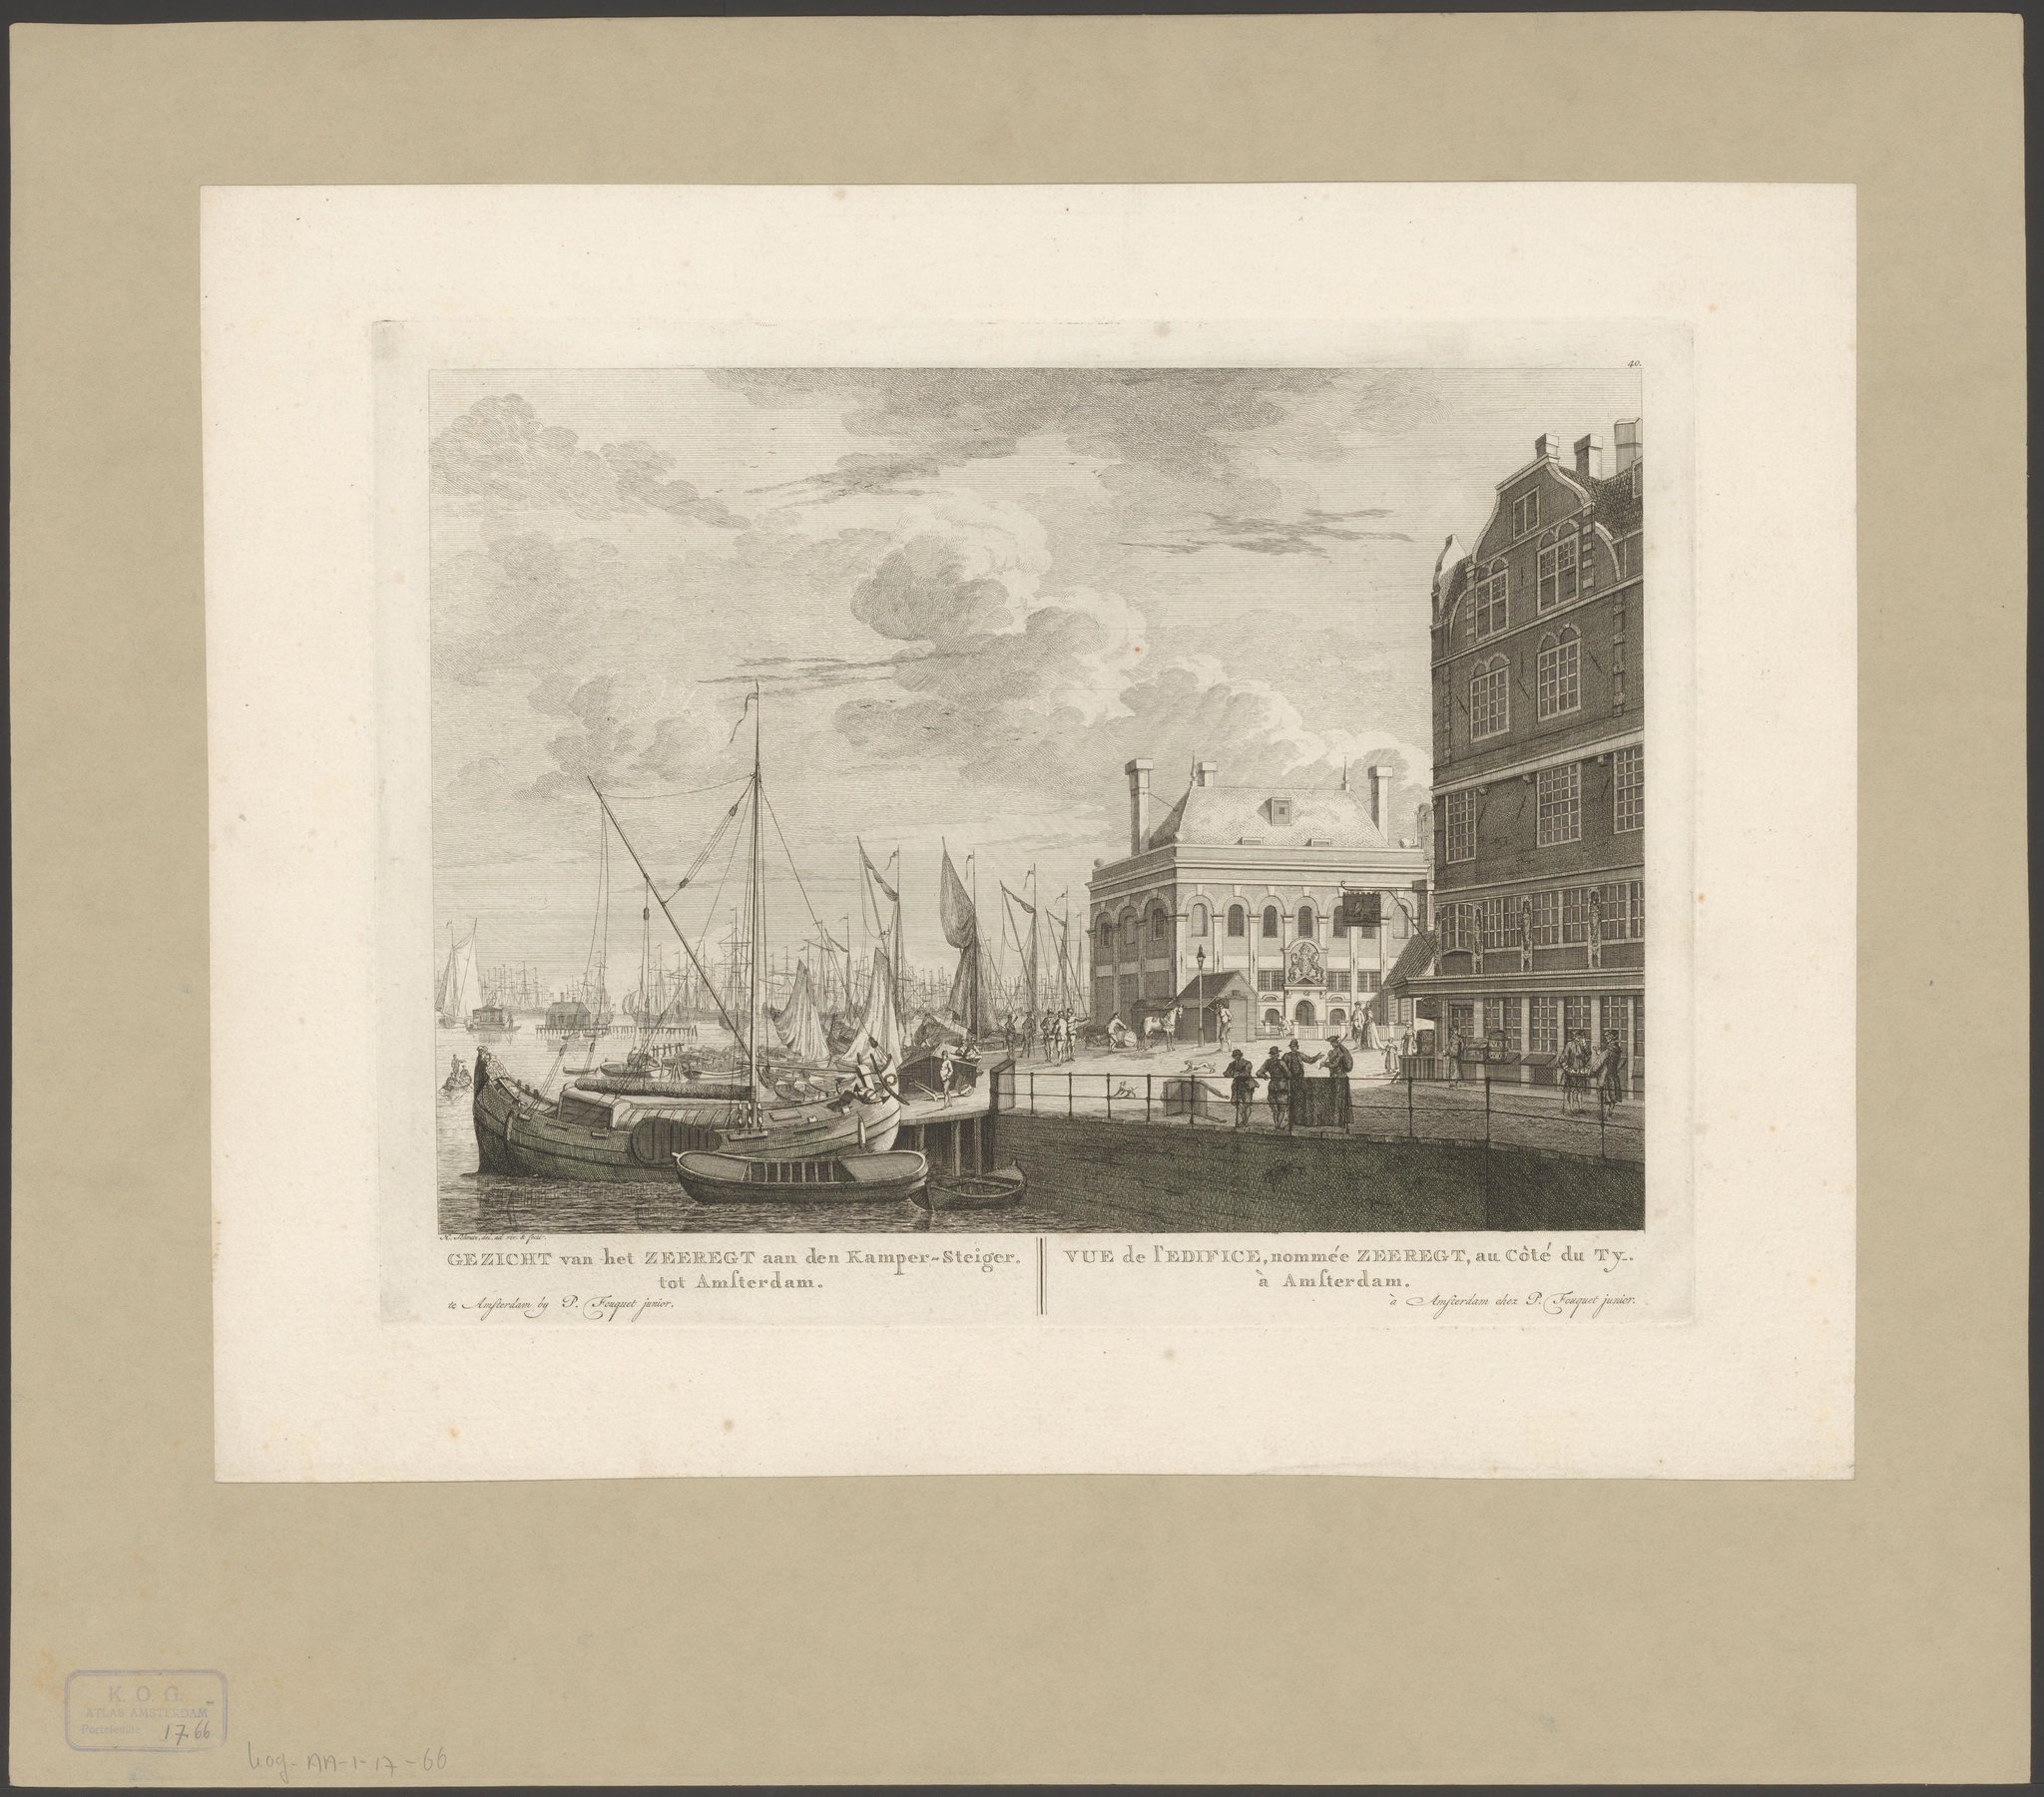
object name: print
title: Gezicht op het gebouw Zeerecht aan de Kampersteiger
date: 1770-1783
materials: paper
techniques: engraving, etching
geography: amsterdam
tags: sailing-ship, sailing-boat, city-view in general; 'veduta', river, façade (of house or building)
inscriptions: collector's mark: ‘17.66’ Lugt 1641b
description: Deze prent is ook gebruikt in de zogenaamde Atlas van Fouquet.* Pierre Fouquet gaf vanaf 1760 stadsgezichten van Amsterdam - naar tekeningen van verschillende kunstenaars, gemaakt door verschillende prentmakers - uit. Deze prenten werden aanvankelijk los of in series verkocht. Zoals toen gebruikelijk kon de koper de prenten zelf laten inbinden. Hiertoe gaf Fouquet tussen 1778 en 1783 een titelblad, plattegrond en inhoudsopgave van de tot dusver 100 uitgegeven prenten uit (1). Gezien de inhoud afhankelijk was van wat de koper had verzameld verschilt de inhoud van de verschillende bewaarde Fouquetatlassen onder deze titel sterk. Ook zijn er exemplaren bekend waar tevens andere prenten aan zijn toegevoegd. Omdat er behoefte bleek aan uitleg bij de platen werd in 1783 een nieuwe versie van de atlas uitgegeven, aangevuld met tekst en twee prenten. De aangegeven volgorde veranderde maar de platen van de al eerder uitgegeven prenten bleven ongewijzigd. Deze uitgave werd in opdracht van Fouquet gedrukt bij Daniël Jean Changuion en Petrus den Hengst (2). Een tiental platen werd bijgewerkt en verscheen, met nieuw impressum, in het vervolg van Wagenaars geschiedenis van Amsterdam, uitgeven door Petrus Conradi en Folkert van der Plaats (3). Een aantal jaar na het overlijden van Fouquet kwam Evert Maaskamp met een nieuwe uitgave van de atlas, met verbeterde tekst en toevoeging van twee prenten. Op alle platen verwijderde hij het oude en liet hij zijn eigen impressum zetten (4). De huidige staat van de prent komt voor in exemplaren van de onder (1) en (2) genoemde werken. * Onder de Atlas van Fouquet of Fouquetatlas verstaan we de hieronder vermelde publicaties (1), (2) en (4). (1). Afbeeldingen van de wyd-vermaarde koopstad Amsterdam benevens des zelvs voornaamste gebouwen en gezigten alle naar het leeven getekend / Receuil des edifices les plus considerables et des plus belles vues, de la fameuse ville d'Amsterdam, dessinées d'après nature. Amsterdam: Pierre Fouquet, 1778-1783. (2). Nieuwe atlas, van de voornaamste gebouwen en gezigten der stad Amsterdam, met derzelver beknopte beschryvingen. 2 delen. Amsterdam: Daniël Jean Changuion en Petrus den Hengst [in opdracht van Pierre Fouquet], 1783. (3). Stijl, Simon. Amsterdam, in zyne geschiedenissen, voorregten, koophandel, gebouwen, kerkenstaat, schoolen, schutterye, gilden en regeeringe, beschreeven. Om te dienen ten vervolge op het werk van Jan Wagenaar (…). 10 delen. Amsterdam en Harlingen: Petrus Conradi en Folkert van der Plaats, 1788-1801. (4). Nieuwe atlas, van de voornaamste gebouwen en gezigten der stad Amsterdam. Met derzelver beknopte beschryvingen. Amsterdam: Evert Maaskamp, 1805. * Het aantal vermelde staten is gebaseerd op het aantal gevonden staten. Mogelijk zijn er meer staten van deze prent. Zie RP-P-1921-290 voor eerste bekende staat. Zie RP-P-1939-804 voor derde bekende staat.